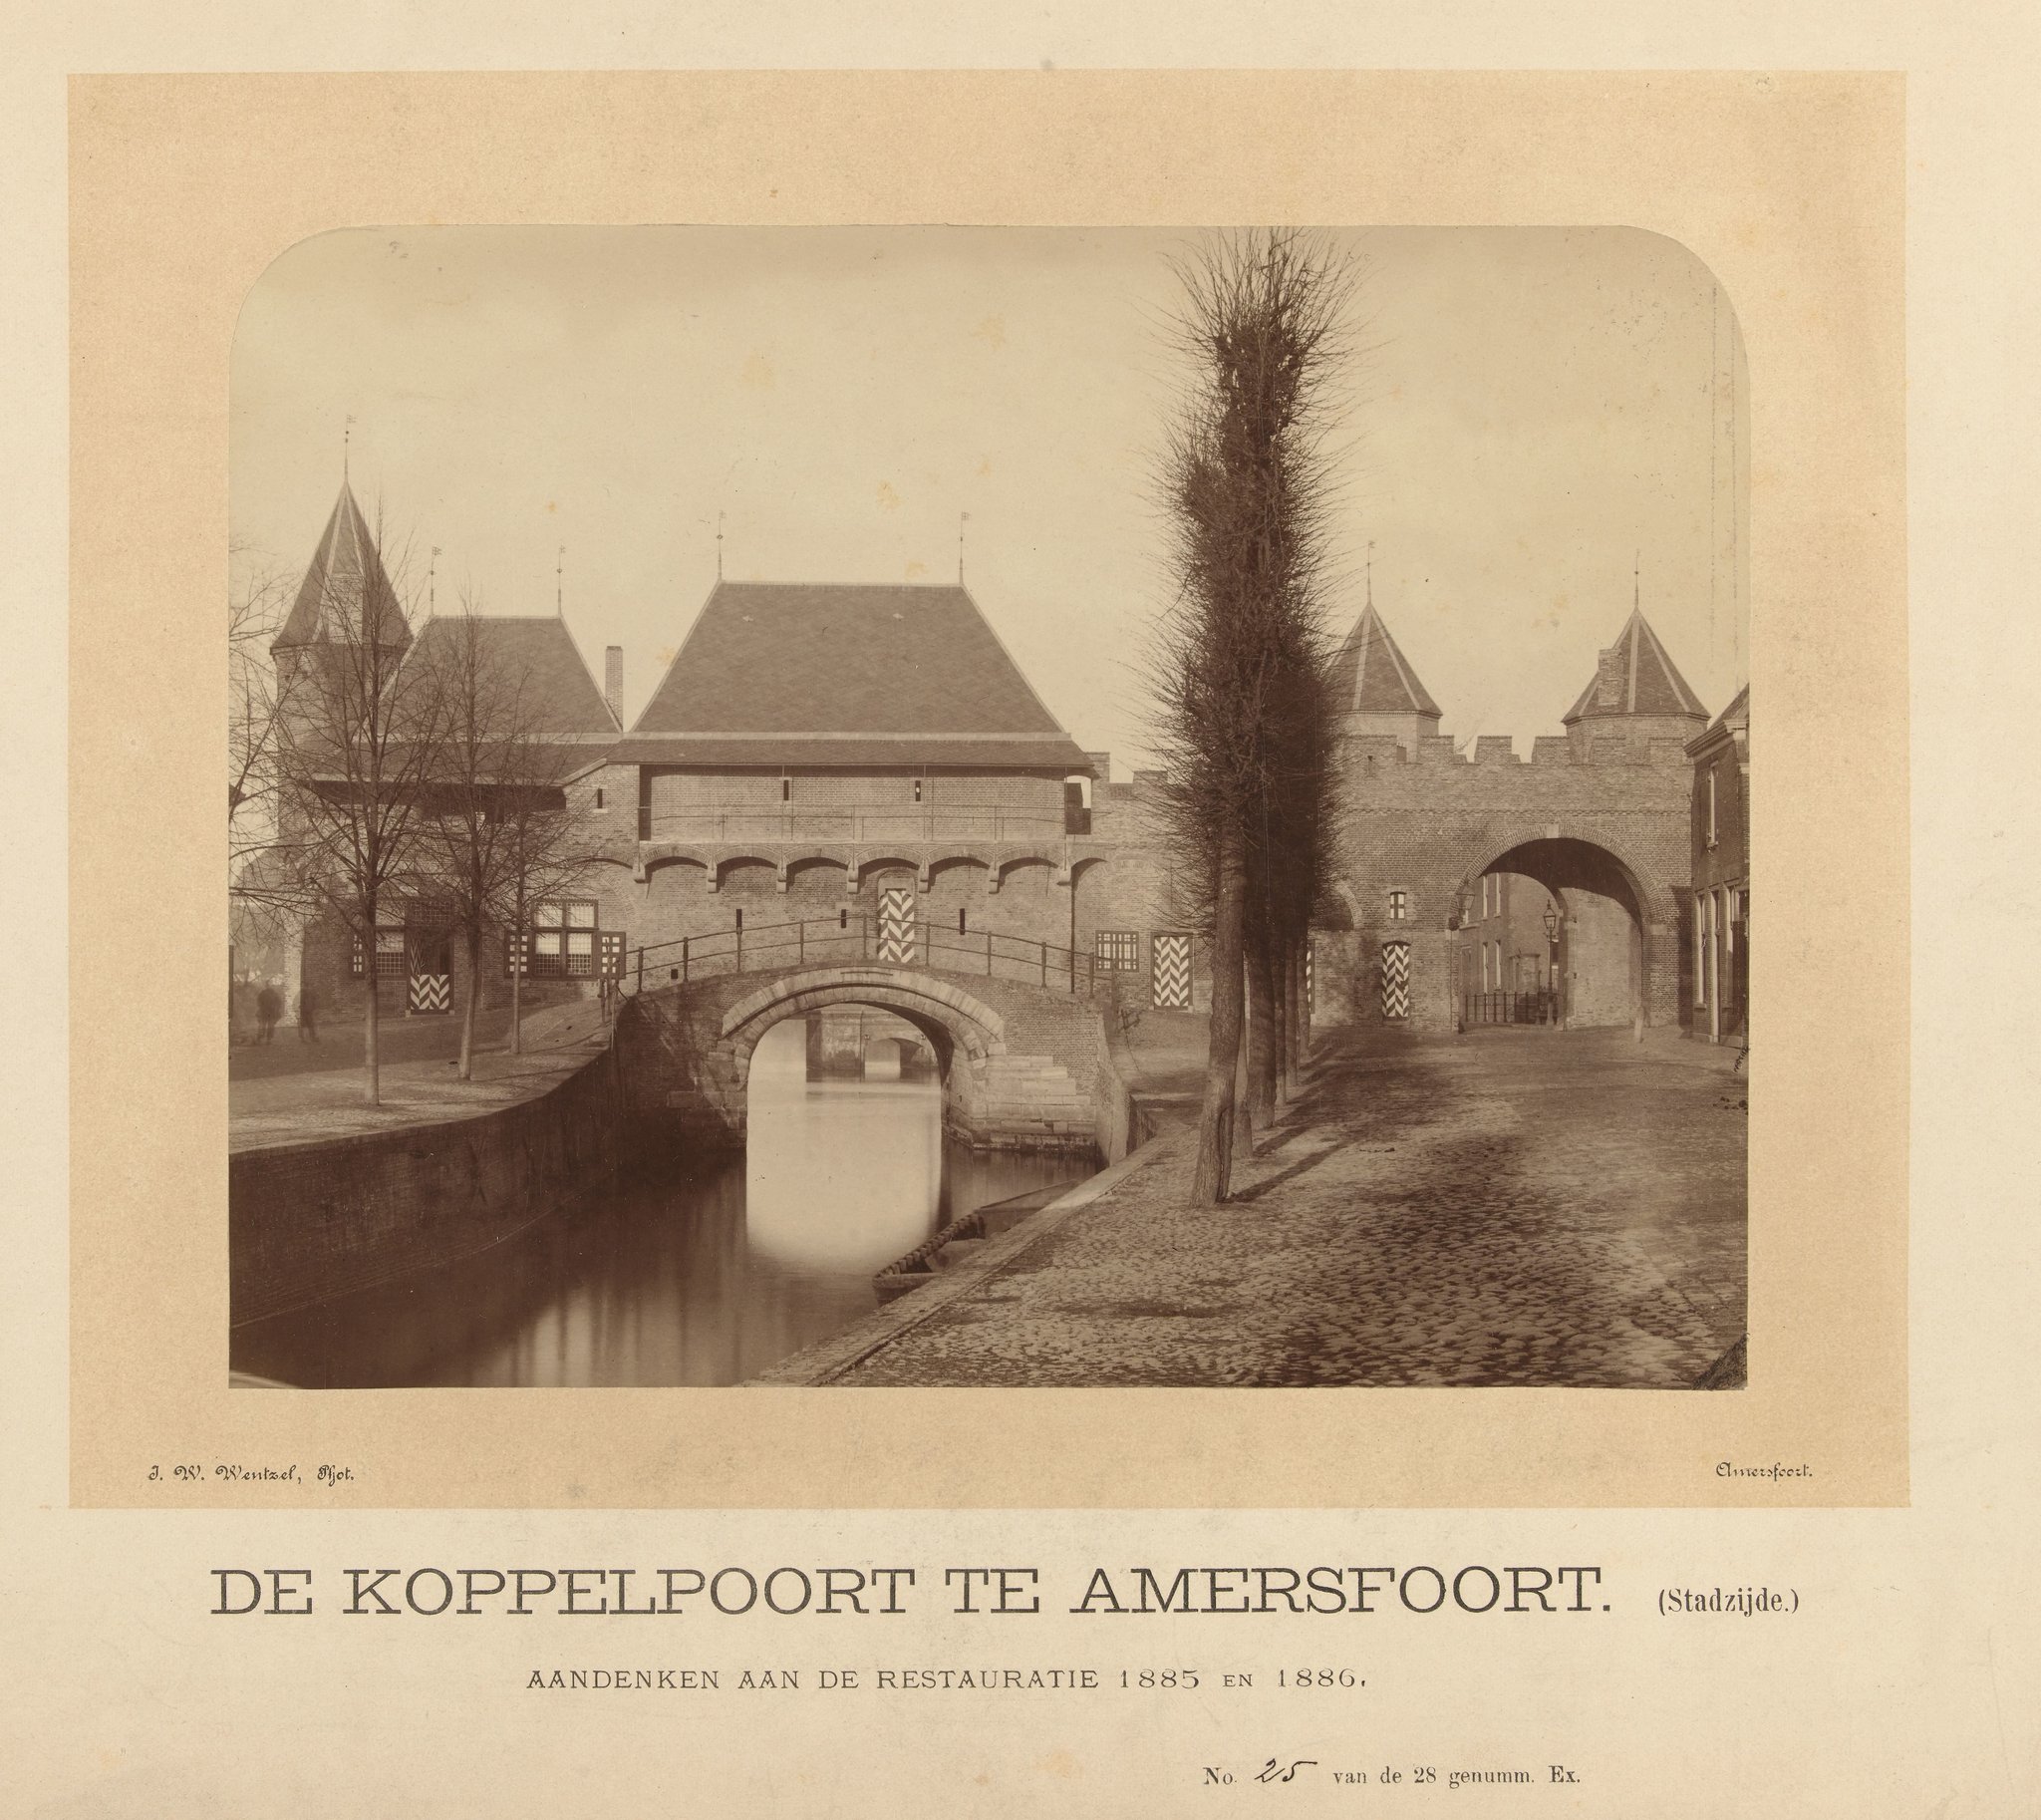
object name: photograph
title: De Koppelpoort te Amersfoort (stadszijde)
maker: j.w. wentzel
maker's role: fotograaf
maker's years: 1855-1930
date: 1886-1887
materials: cardboard, paper, photographic support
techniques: albumen print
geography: amersfoort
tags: city-gate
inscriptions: annotation: ‘De Koppelpoort te Amersfoort (stadszijde) Aandenken aan de restauratie 1885 en 1886. Nr 25 van de 28 genummerd Ex.’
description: Aandenken aan de restauratie 1885 en 1886.